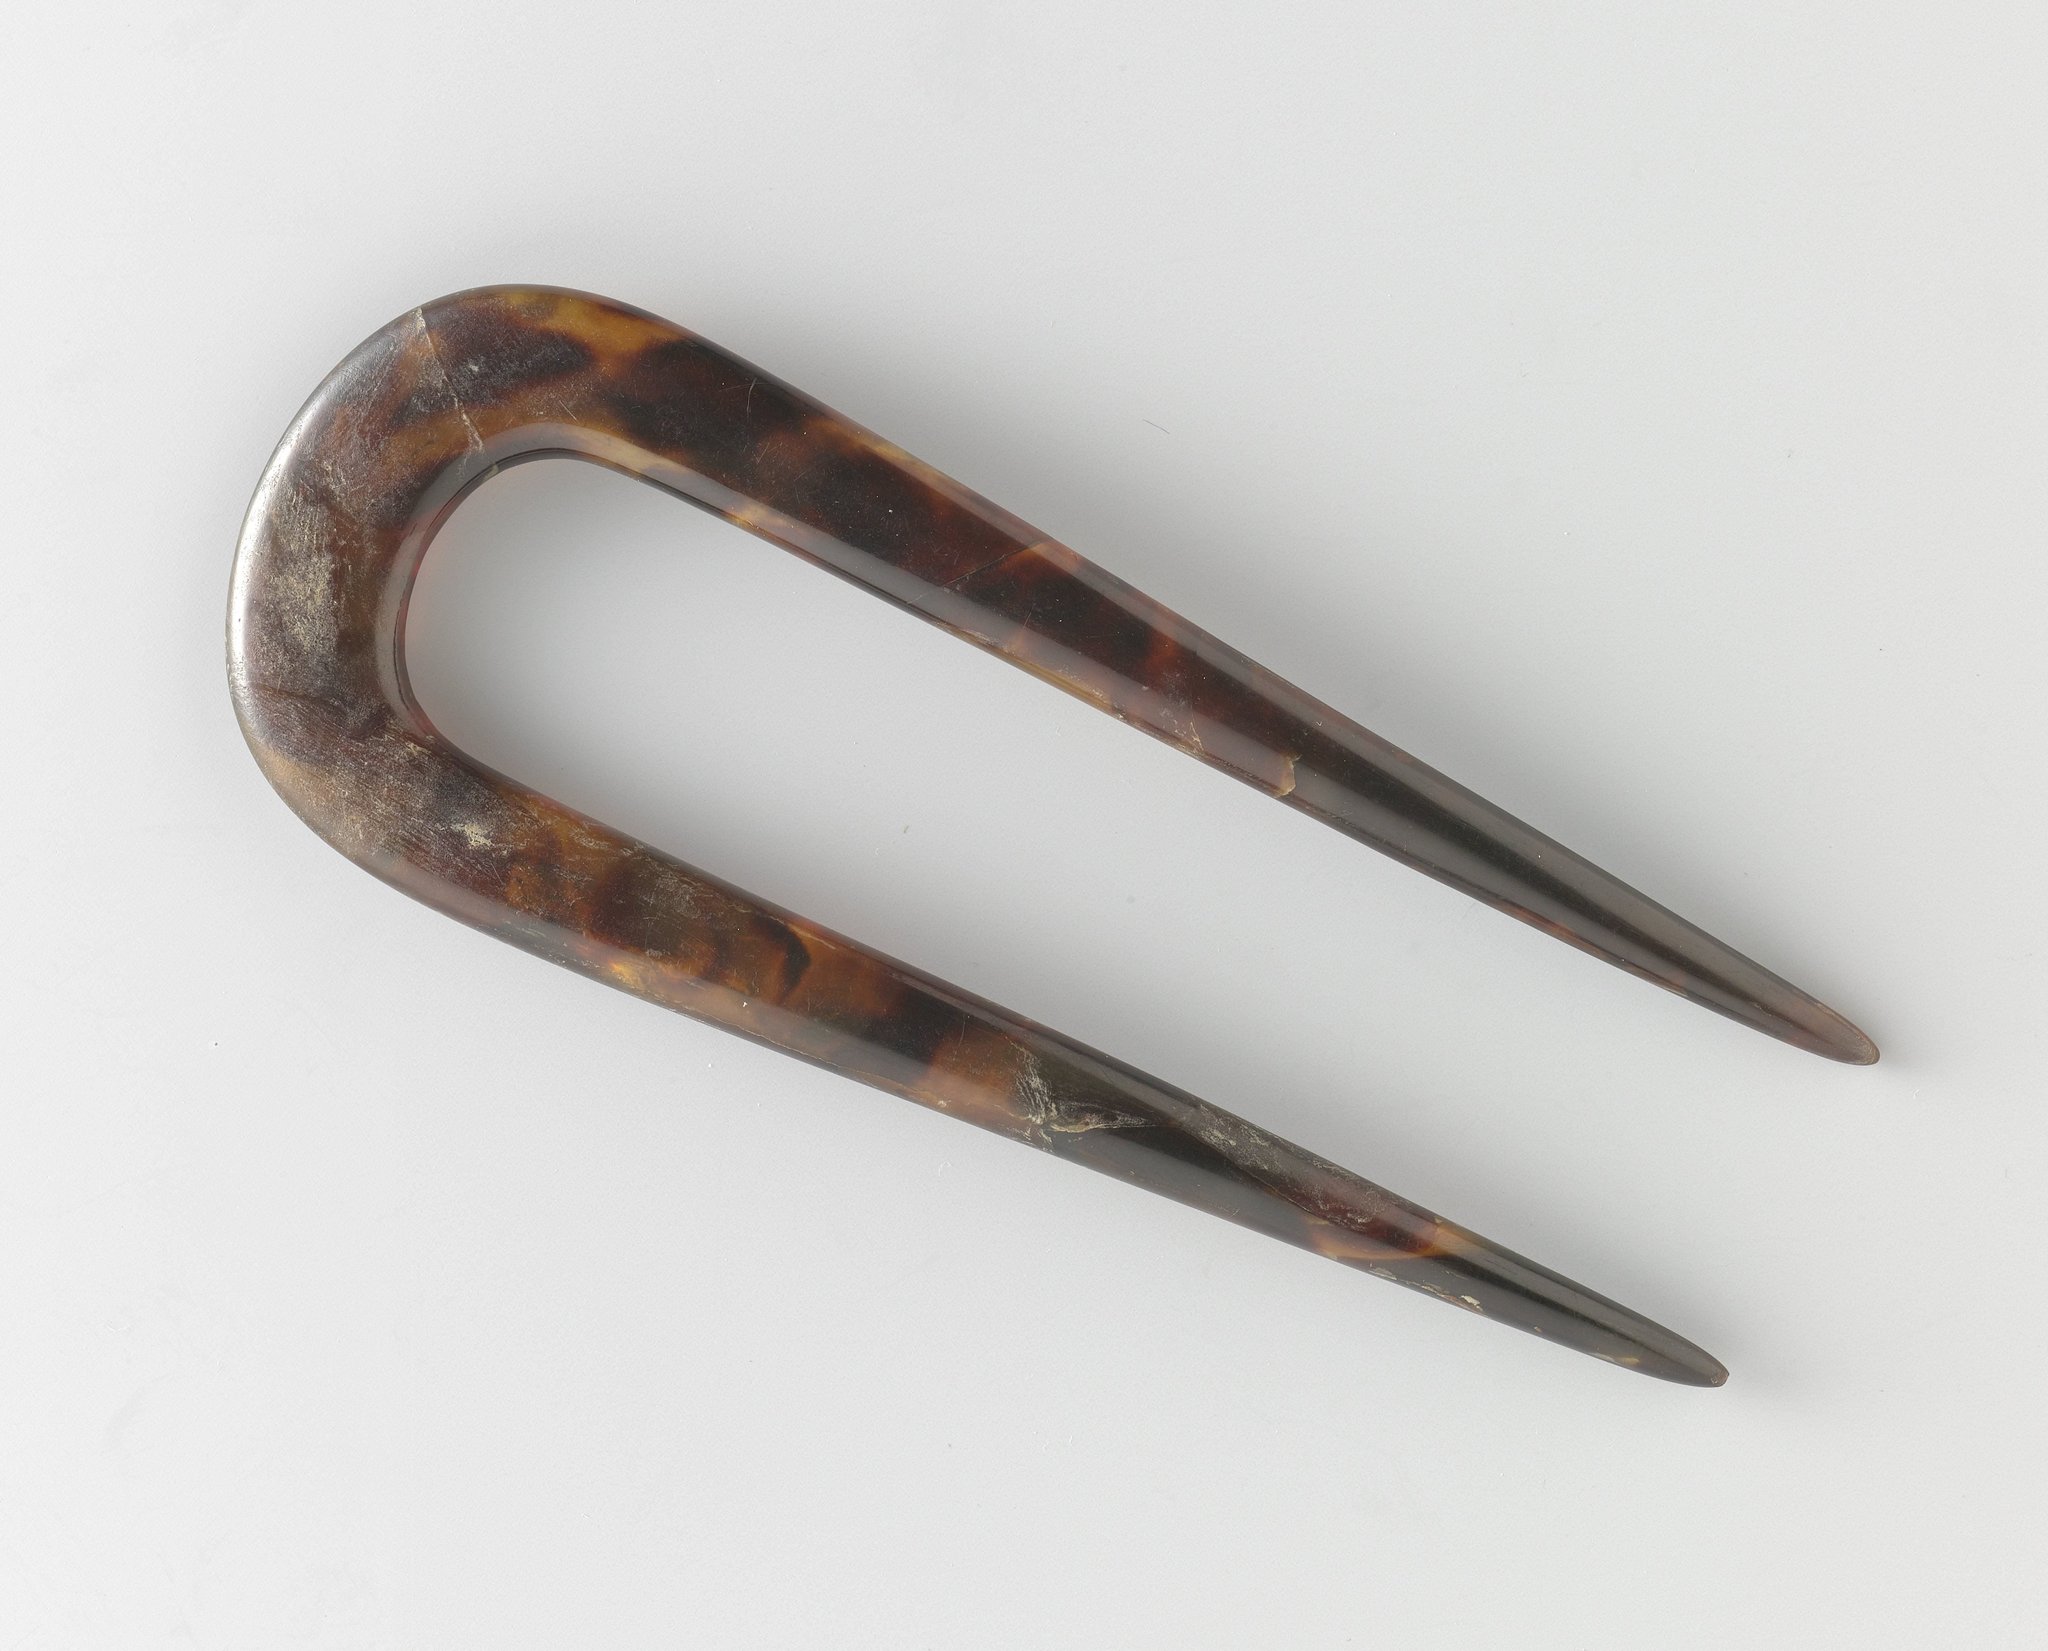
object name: comb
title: Haarkam van schildpad, U-vormig met gladde, afgeronde rug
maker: Anonymous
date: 1885-1900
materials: horn, shell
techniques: assembly, filing, polish, pressing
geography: netherlands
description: Een omgekeerde U-vormige haarnaald. De buitenboog is vierkant de binnenboog afgerond. Van donker schildpad.